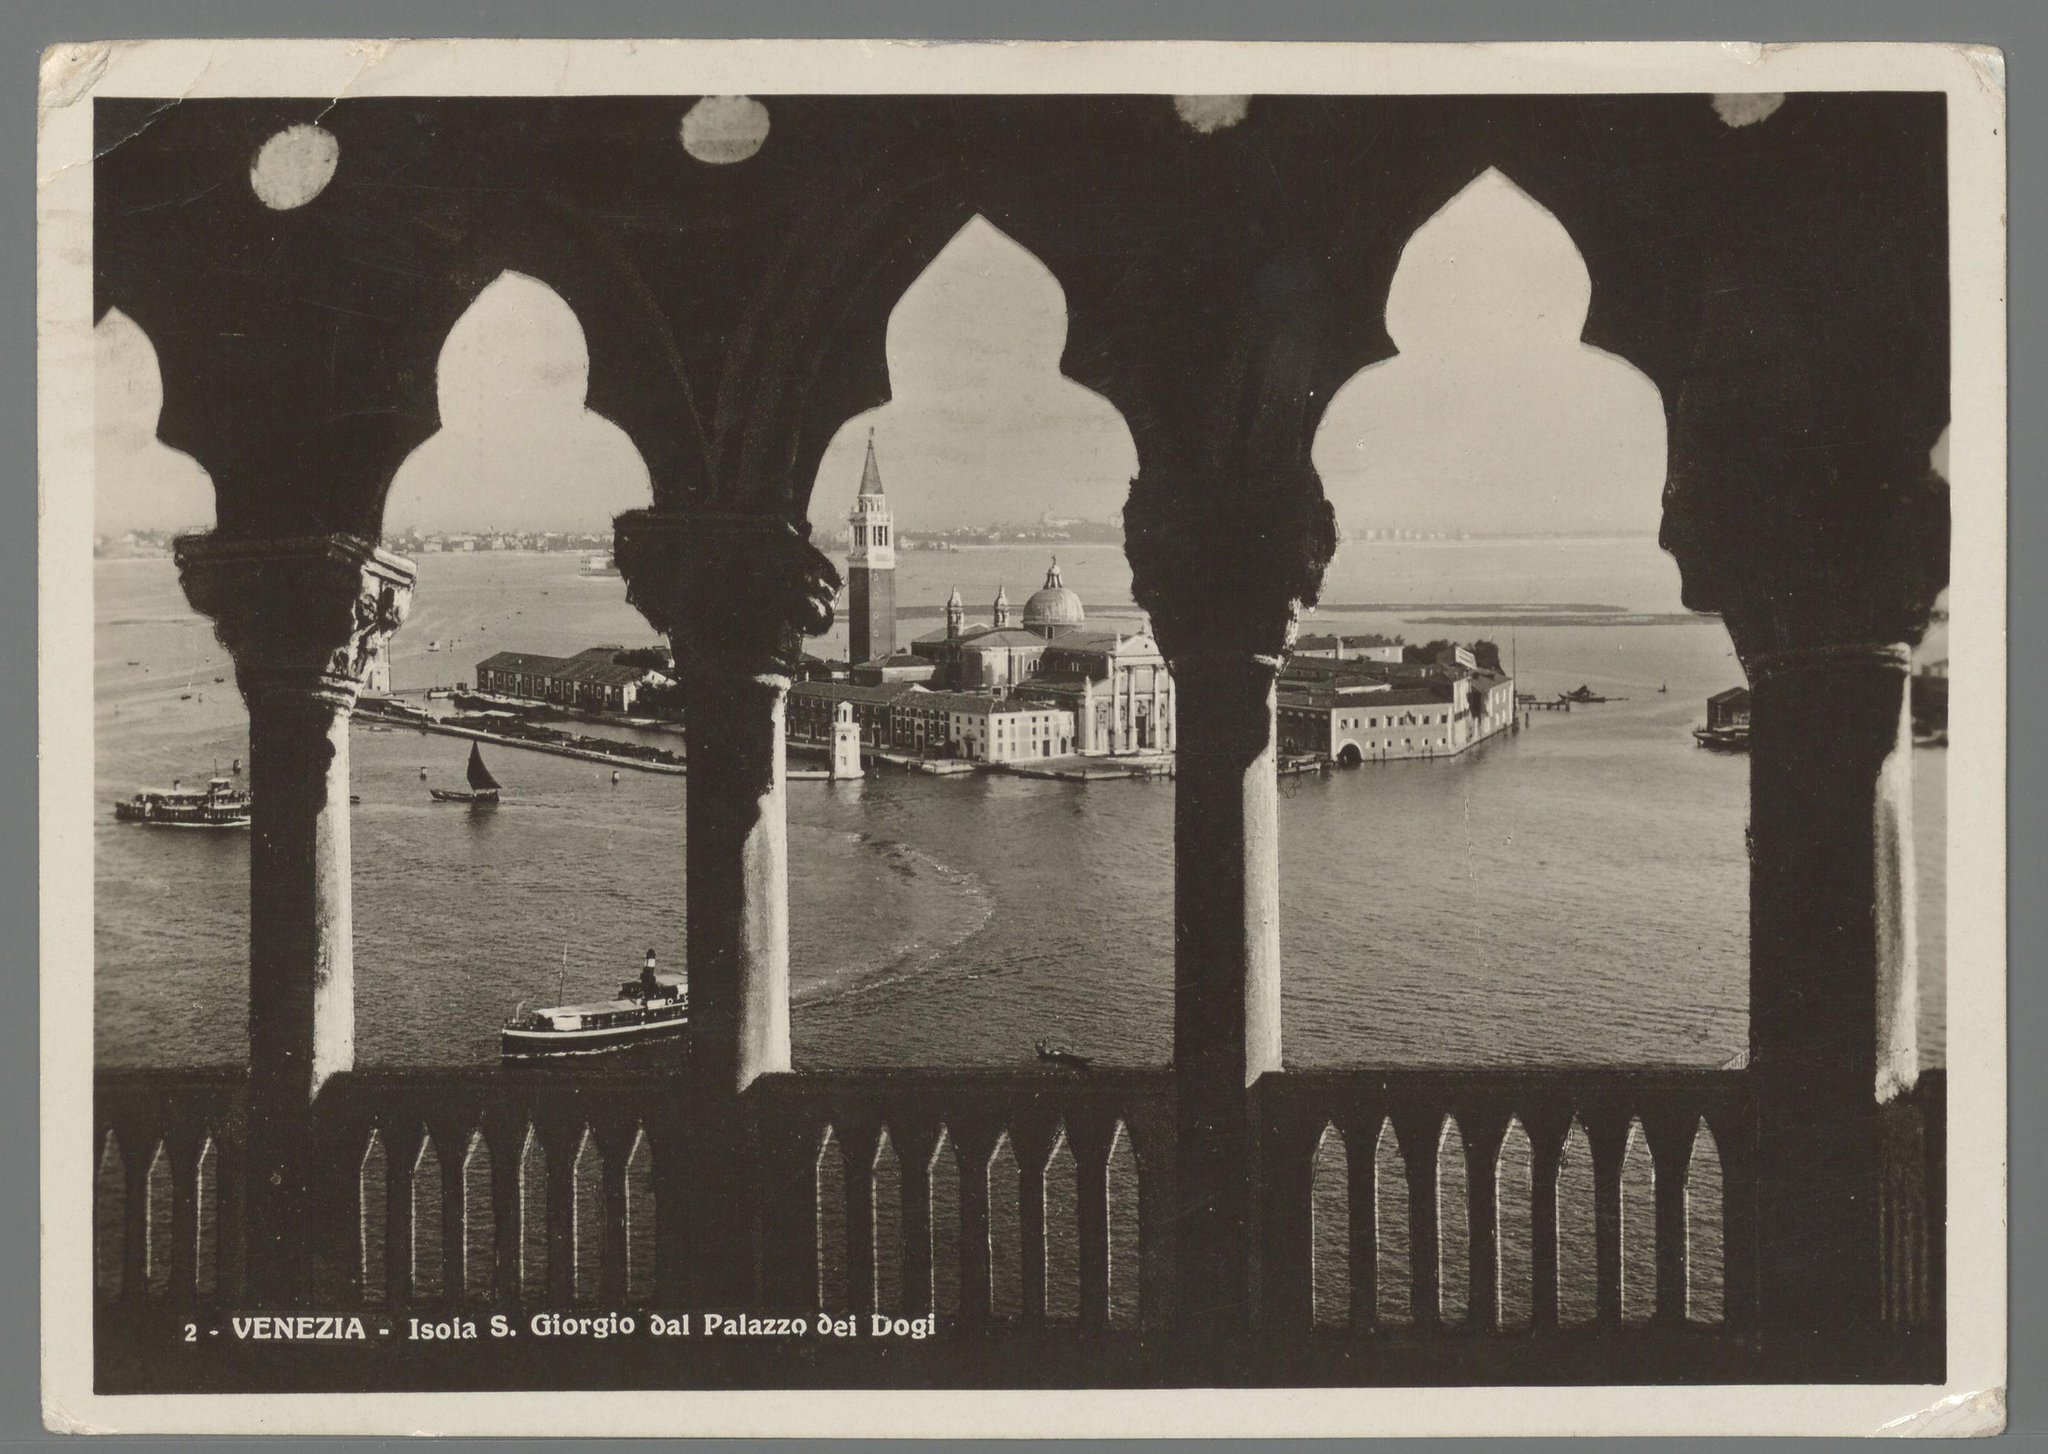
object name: photograph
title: Venezia. Isola S. Giorgio dal Palazzo dei Dogi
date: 1929-1934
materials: photographic support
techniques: photography, writing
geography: milan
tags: island, church (exterior)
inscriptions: postage stamp